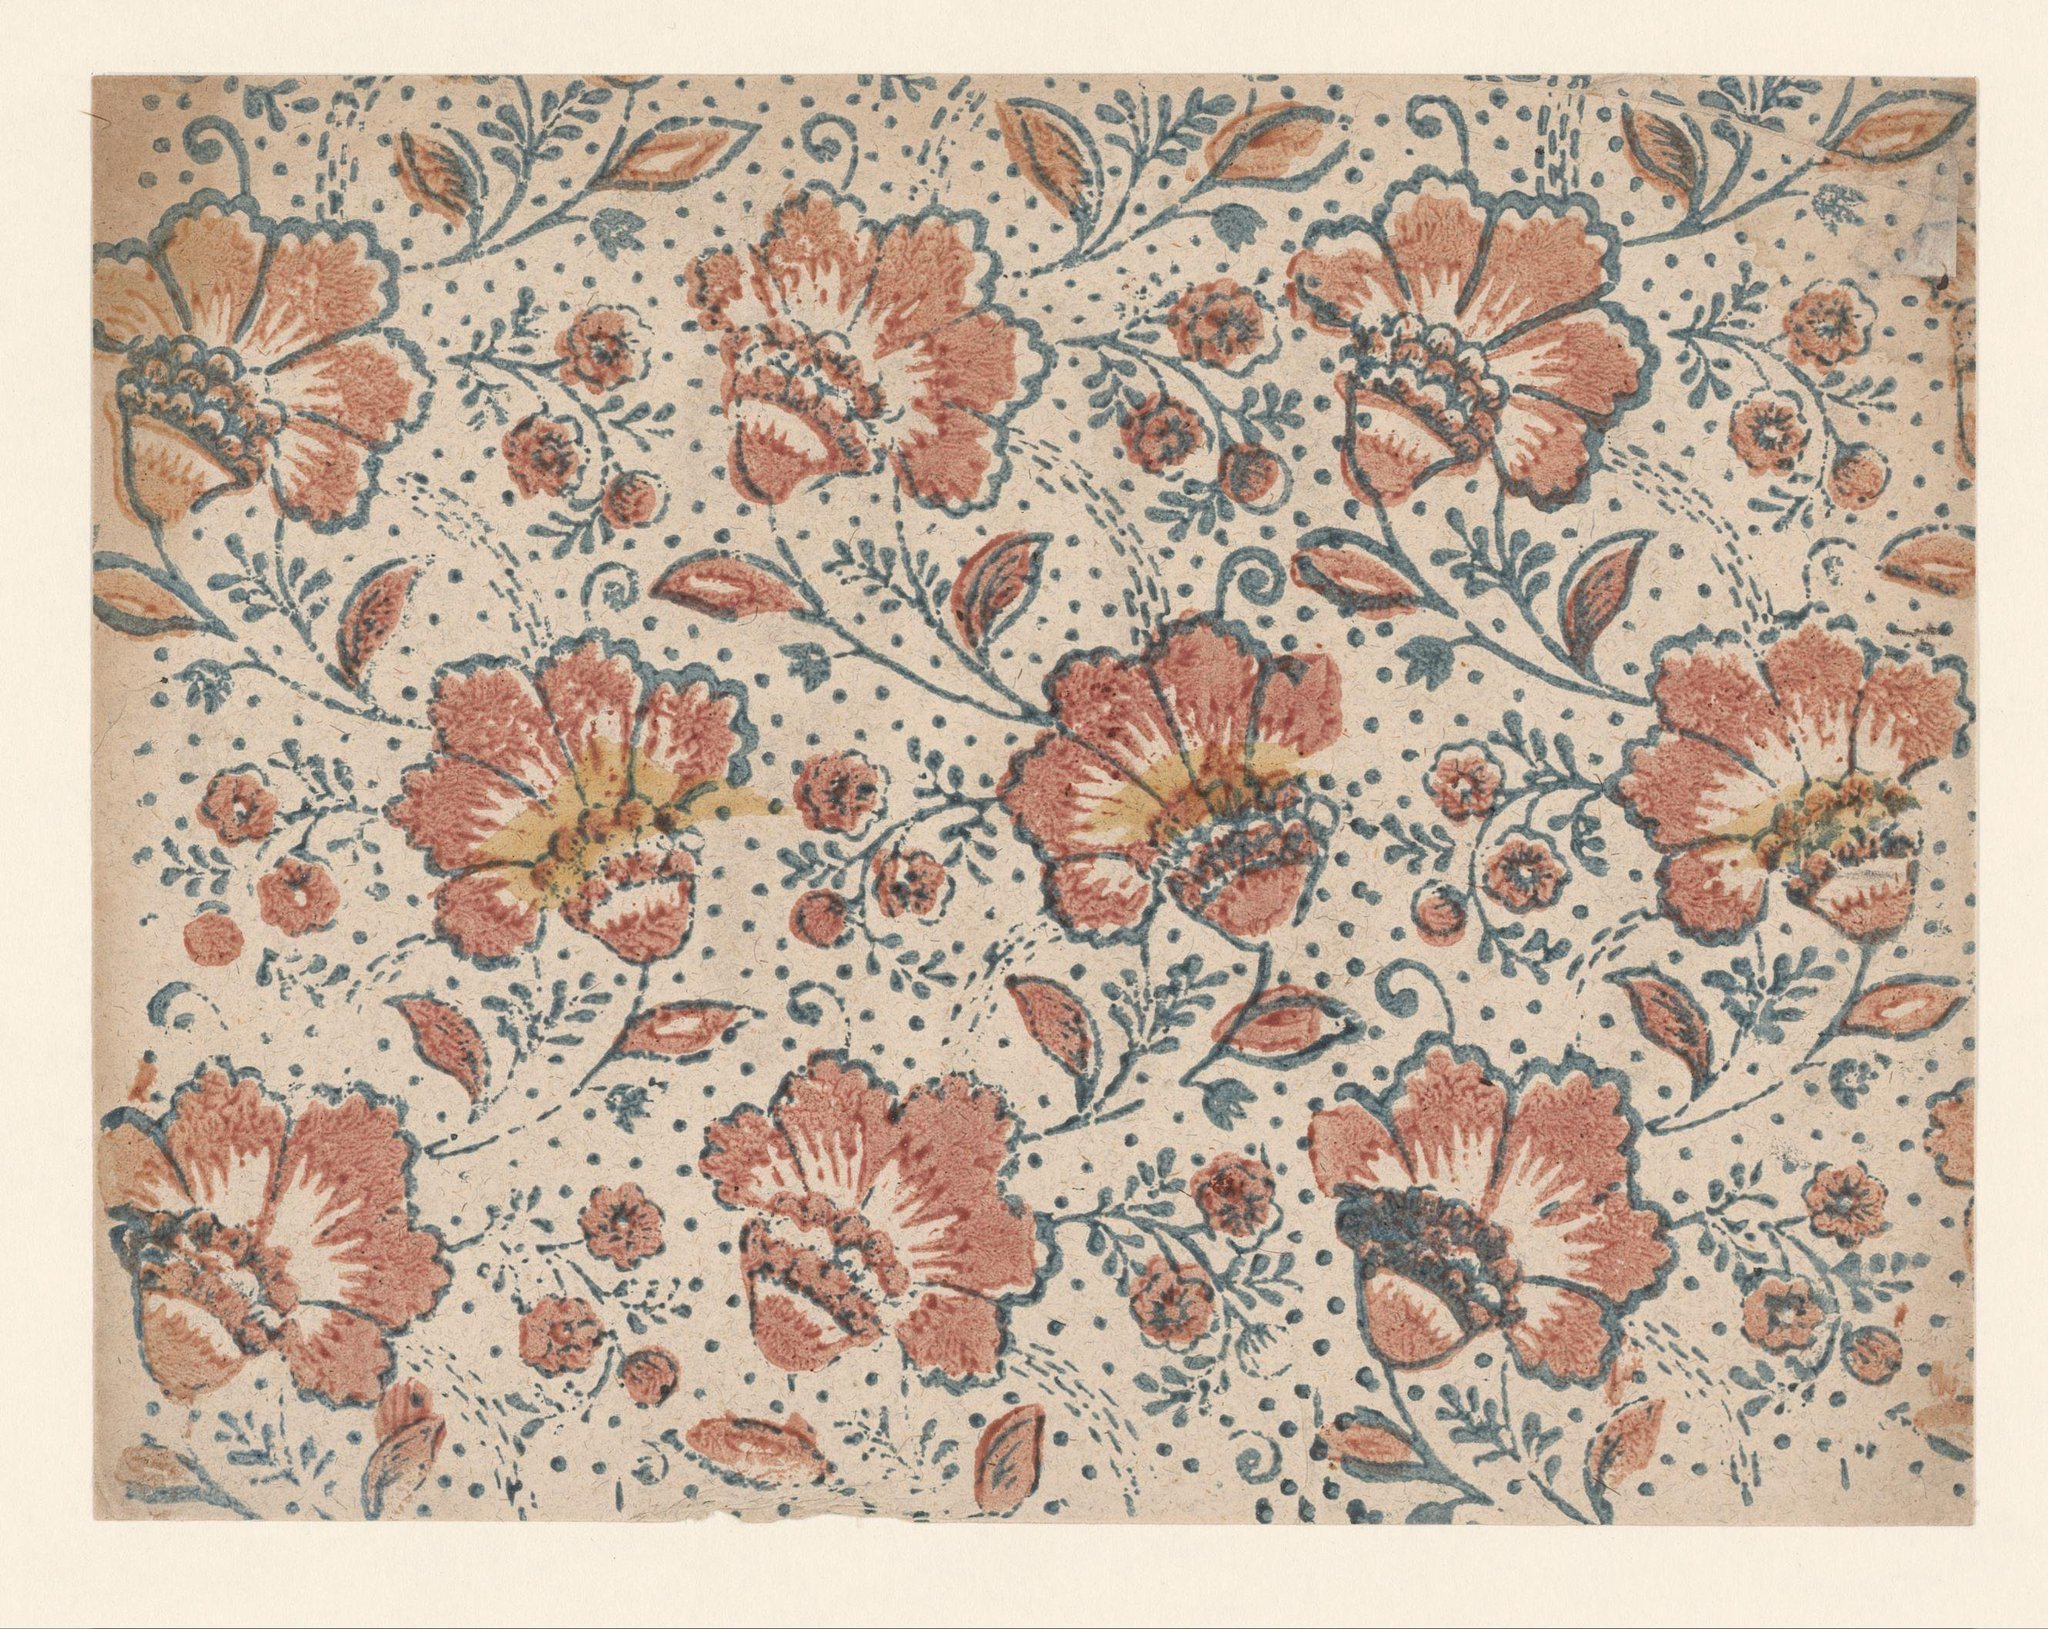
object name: printed paper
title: Blad met patroon van bloemen met stippenfond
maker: Anonymous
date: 1700-1850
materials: paper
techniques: printing block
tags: ornament derived from plant forms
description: Blad met patroon van bloemen met stippenfond.